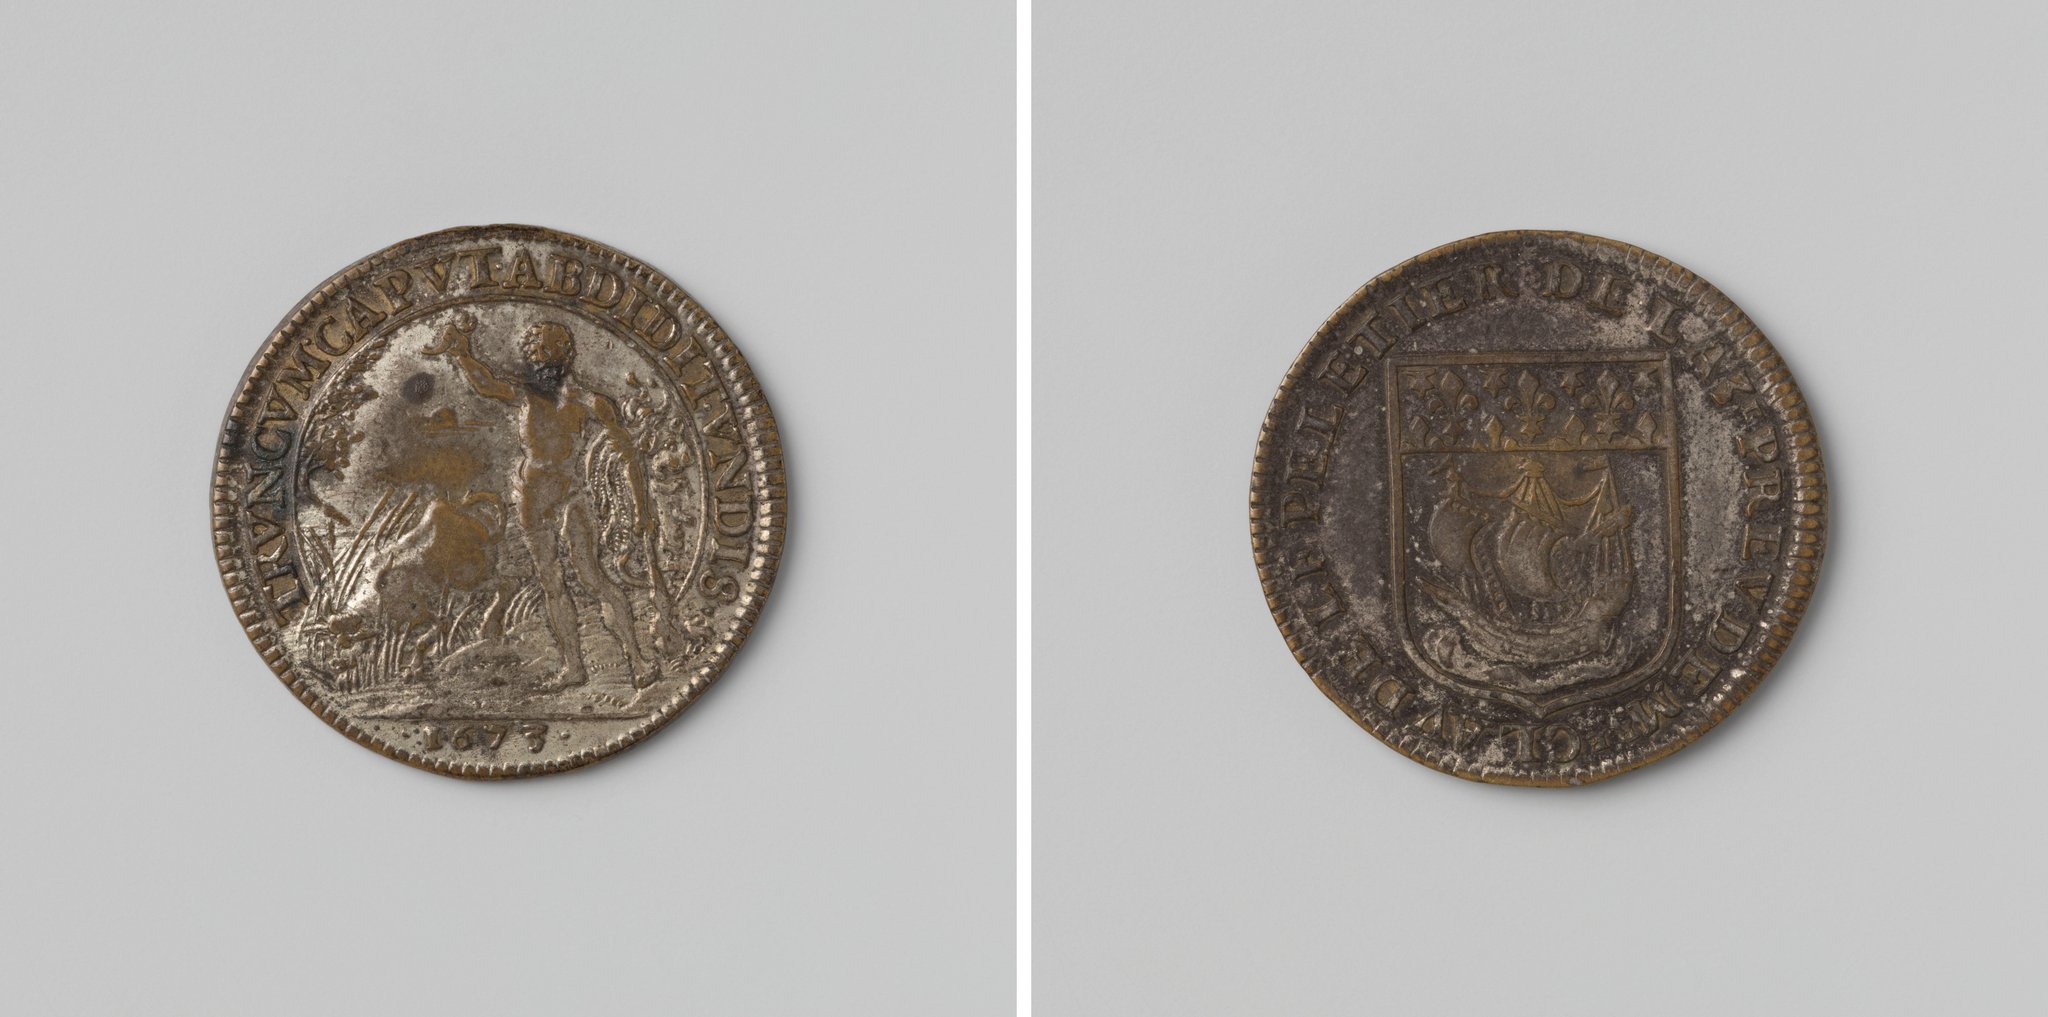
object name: jeton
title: Dreigement aan het adres van de Republiek, wegens het onder water zetten van het land, rekenpenning geslagen ter ere van Claude La Peletier, van het derde provoostschap van de koophandel te Parijs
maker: Anonymous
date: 1673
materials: silver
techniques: striking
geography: france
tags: netherlands, paris